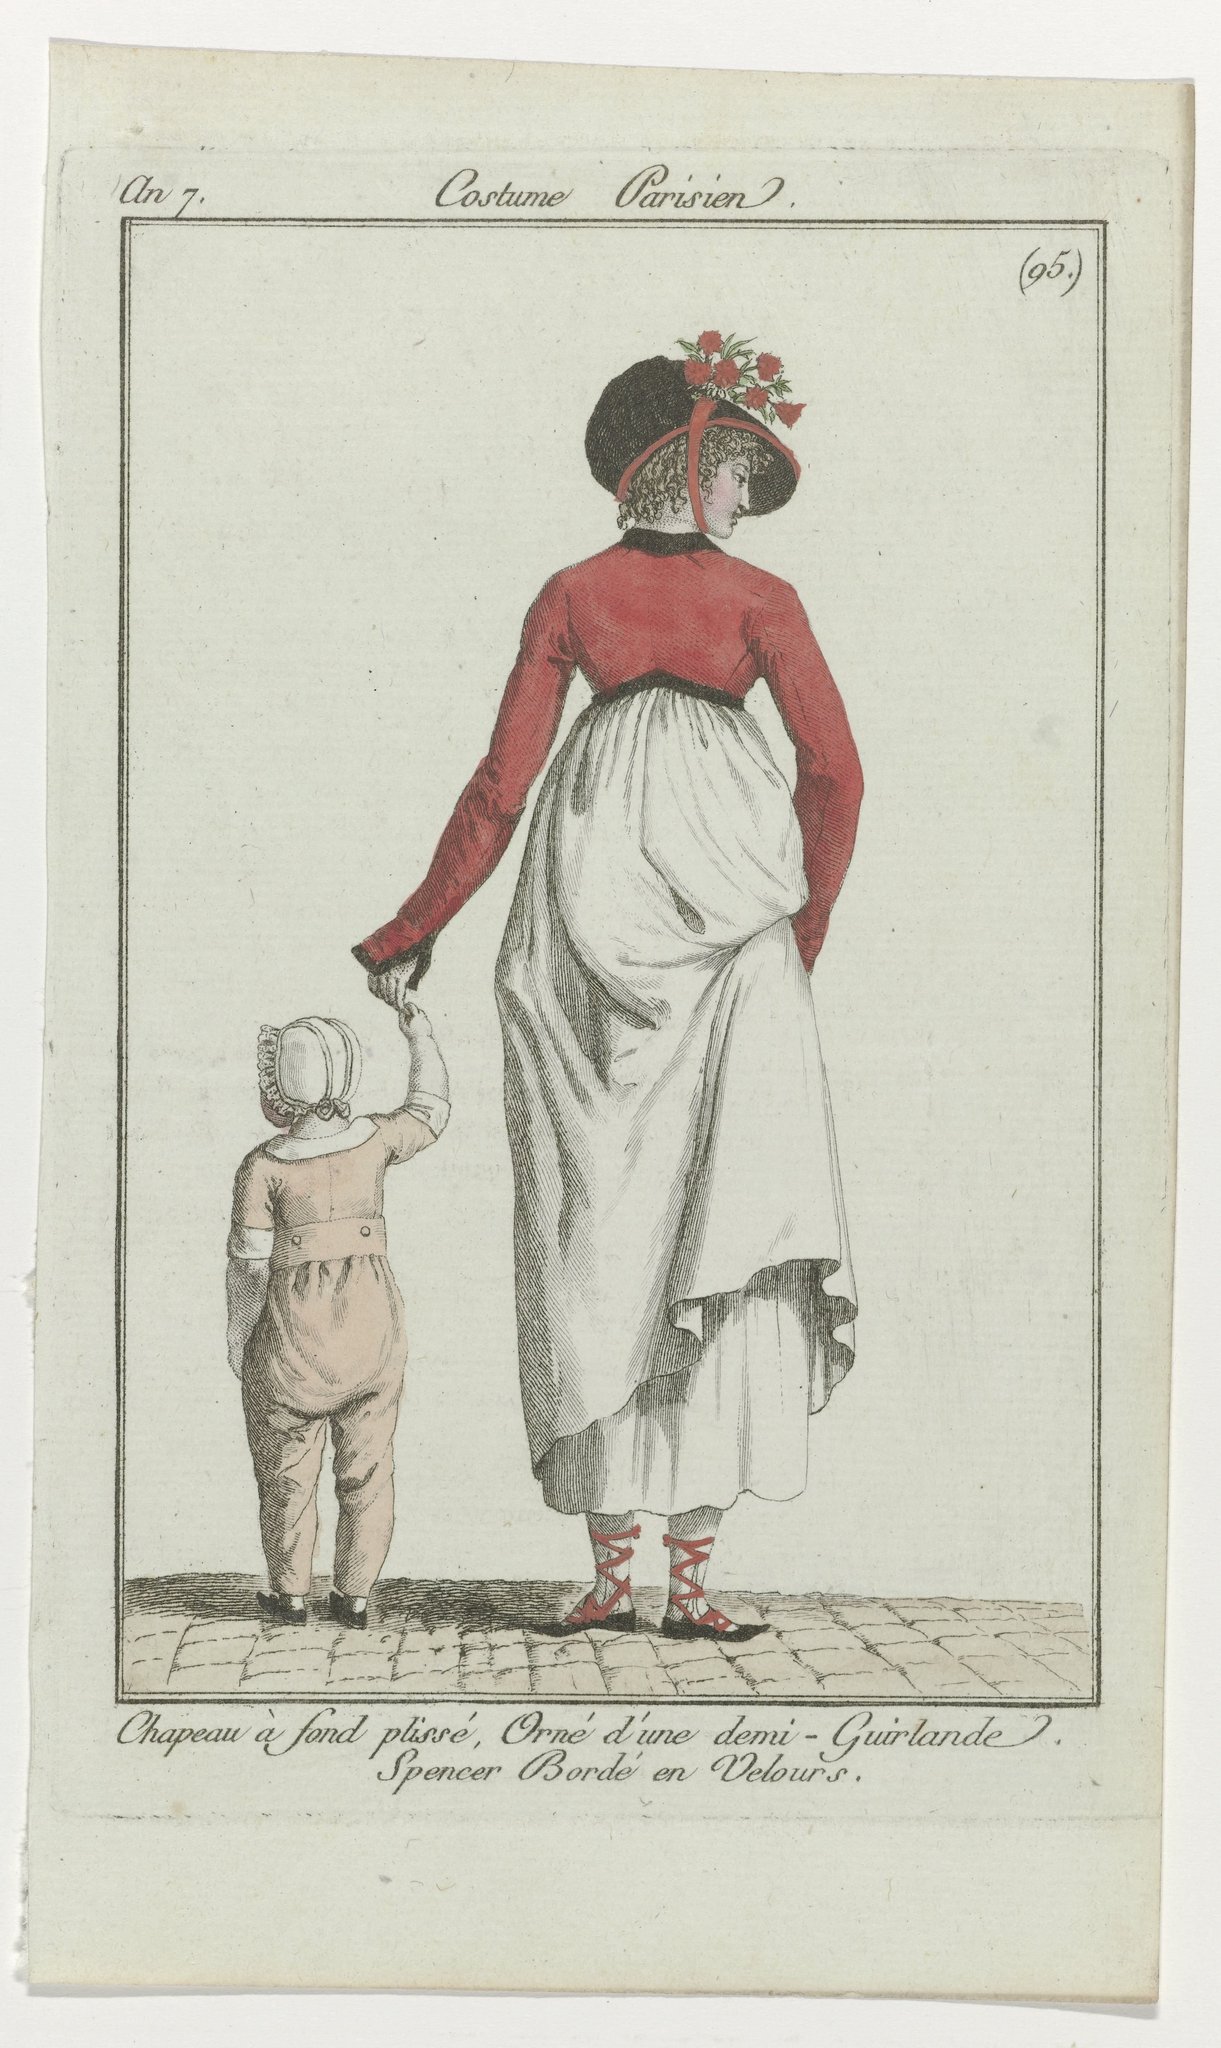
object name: fashion print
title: Journal des Dames et des Modes, Costume Parisien, 15 mars 1799, An 7 (95) : Chapeau à fond plissé (...)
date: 1799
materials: paper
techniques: engraving, hand coloring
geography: paris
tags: clothes, costume (+ children's clothes), head-gear: cap (+ children's clothes), shoes, sandals (+ children's clothes), head-gear (+ children's clothes), skirt (underskirt) (+ women's clothes), clothing for the upper part of the body (spencer) (+ women's clothes), fashion plates, clothes, costume (+ women's clothes), head-gear: hat (+ women's clothes), dress, gown (+ women's clothes), shoes, sandals, stockings, socks (+ women's clothes)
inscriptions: title: ‘Costume Parisien.’, caption: ‘Chapeau à fond plissé, orné d'une demi-Guirlande. Spencer Bordé en Velours.’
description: Vrouw met kind aan de hand. Hoed, van achteren geplooid, versierd met bloemen: 'demi-guirlande'. Spencer afgezet met fluweel. Schoenen met gekruiste linten en puntige neuzen (cothurnes). De prent maakt deel uit van het modetijdschrift Journal des Dames et des Modes, uitgegeven door Sellèque, Parijs, 1797-1839.